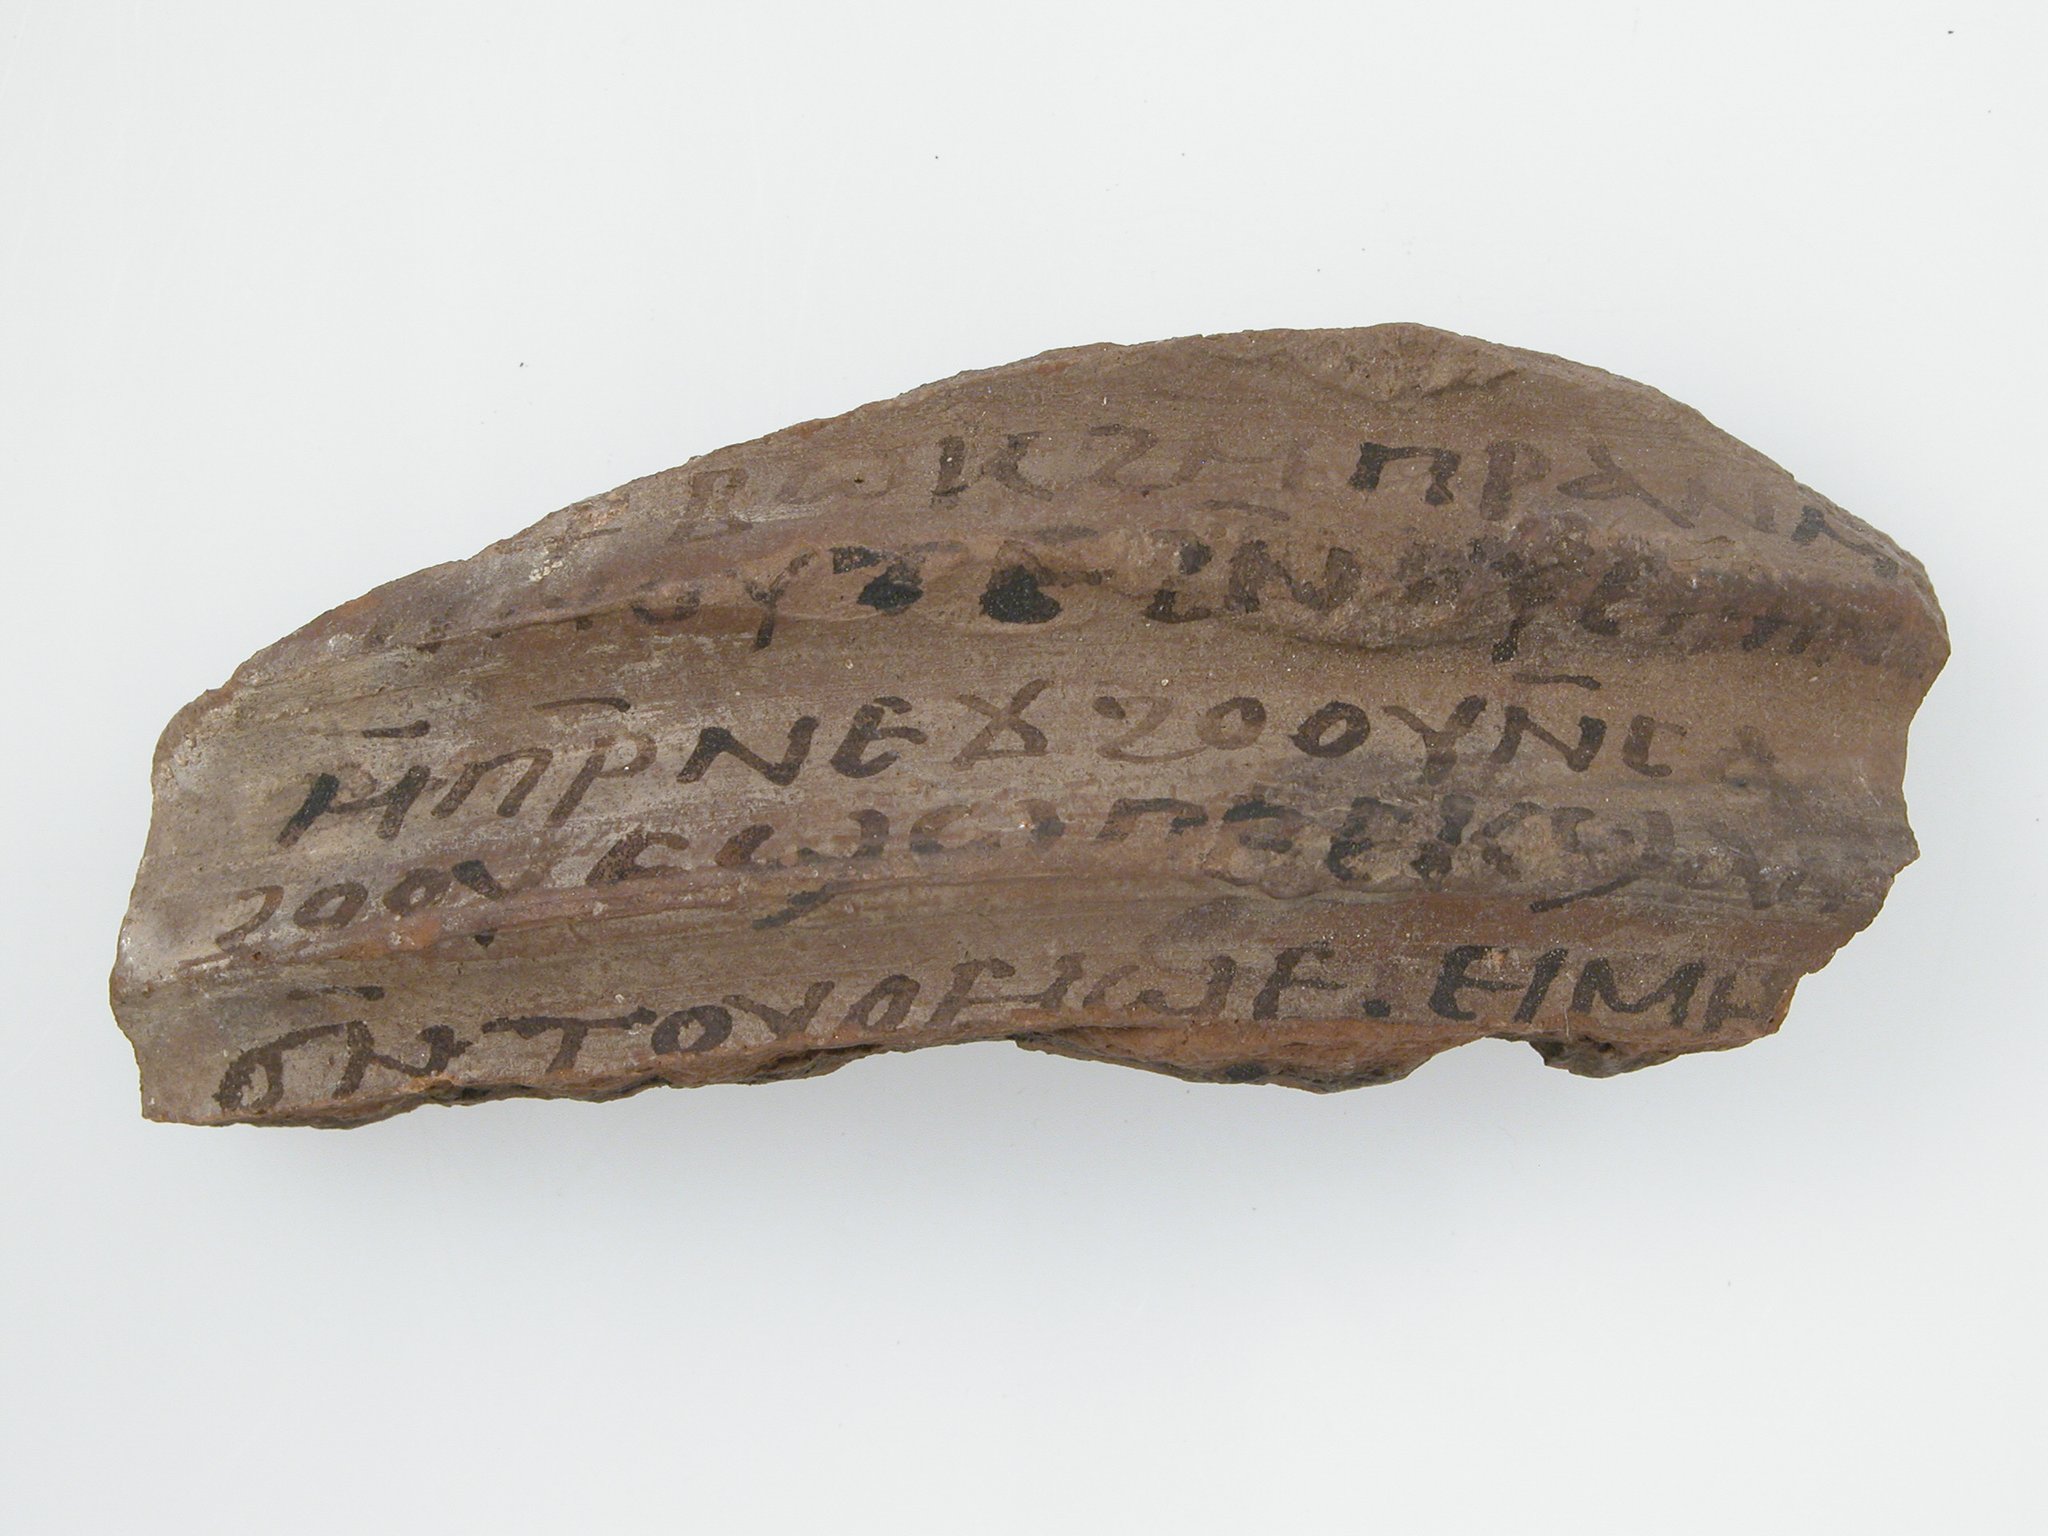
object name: ostrakon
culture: coptic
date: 600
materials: ink, pottery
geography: egypt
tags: coptic,documents